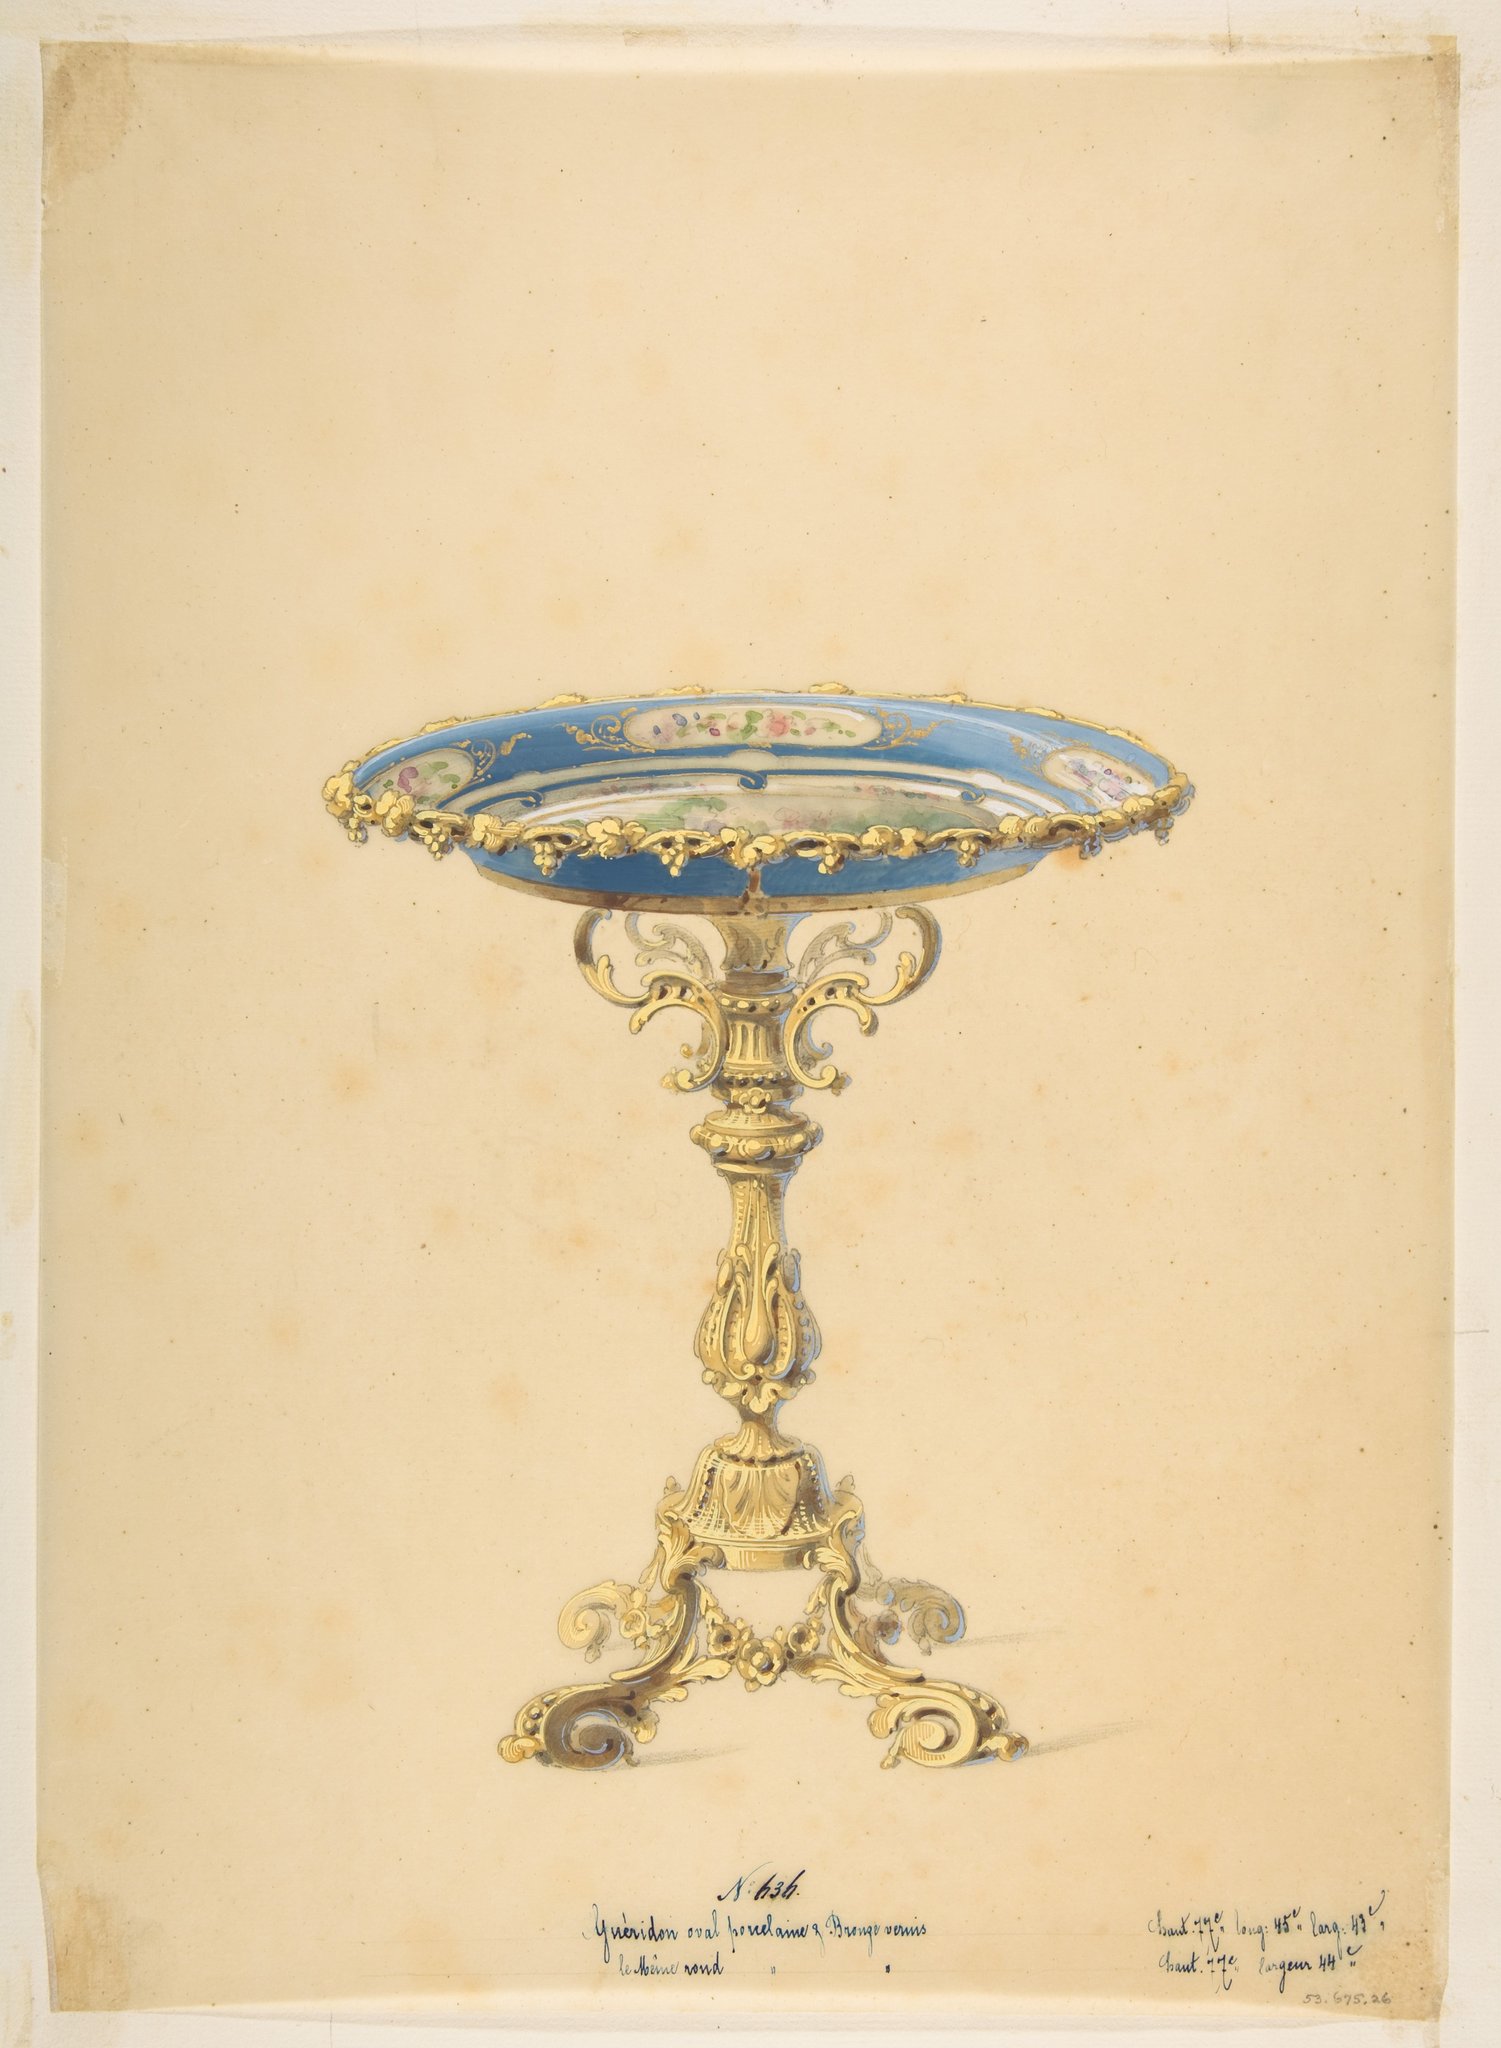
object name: drawing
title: Design for a Round Porcelain Table with Polished Bronze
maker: anonymous, french, 19th century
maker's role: artist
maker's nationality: french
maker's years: 1800-1900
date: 1801-1900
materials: gouache, graphite, watercolor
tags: tables